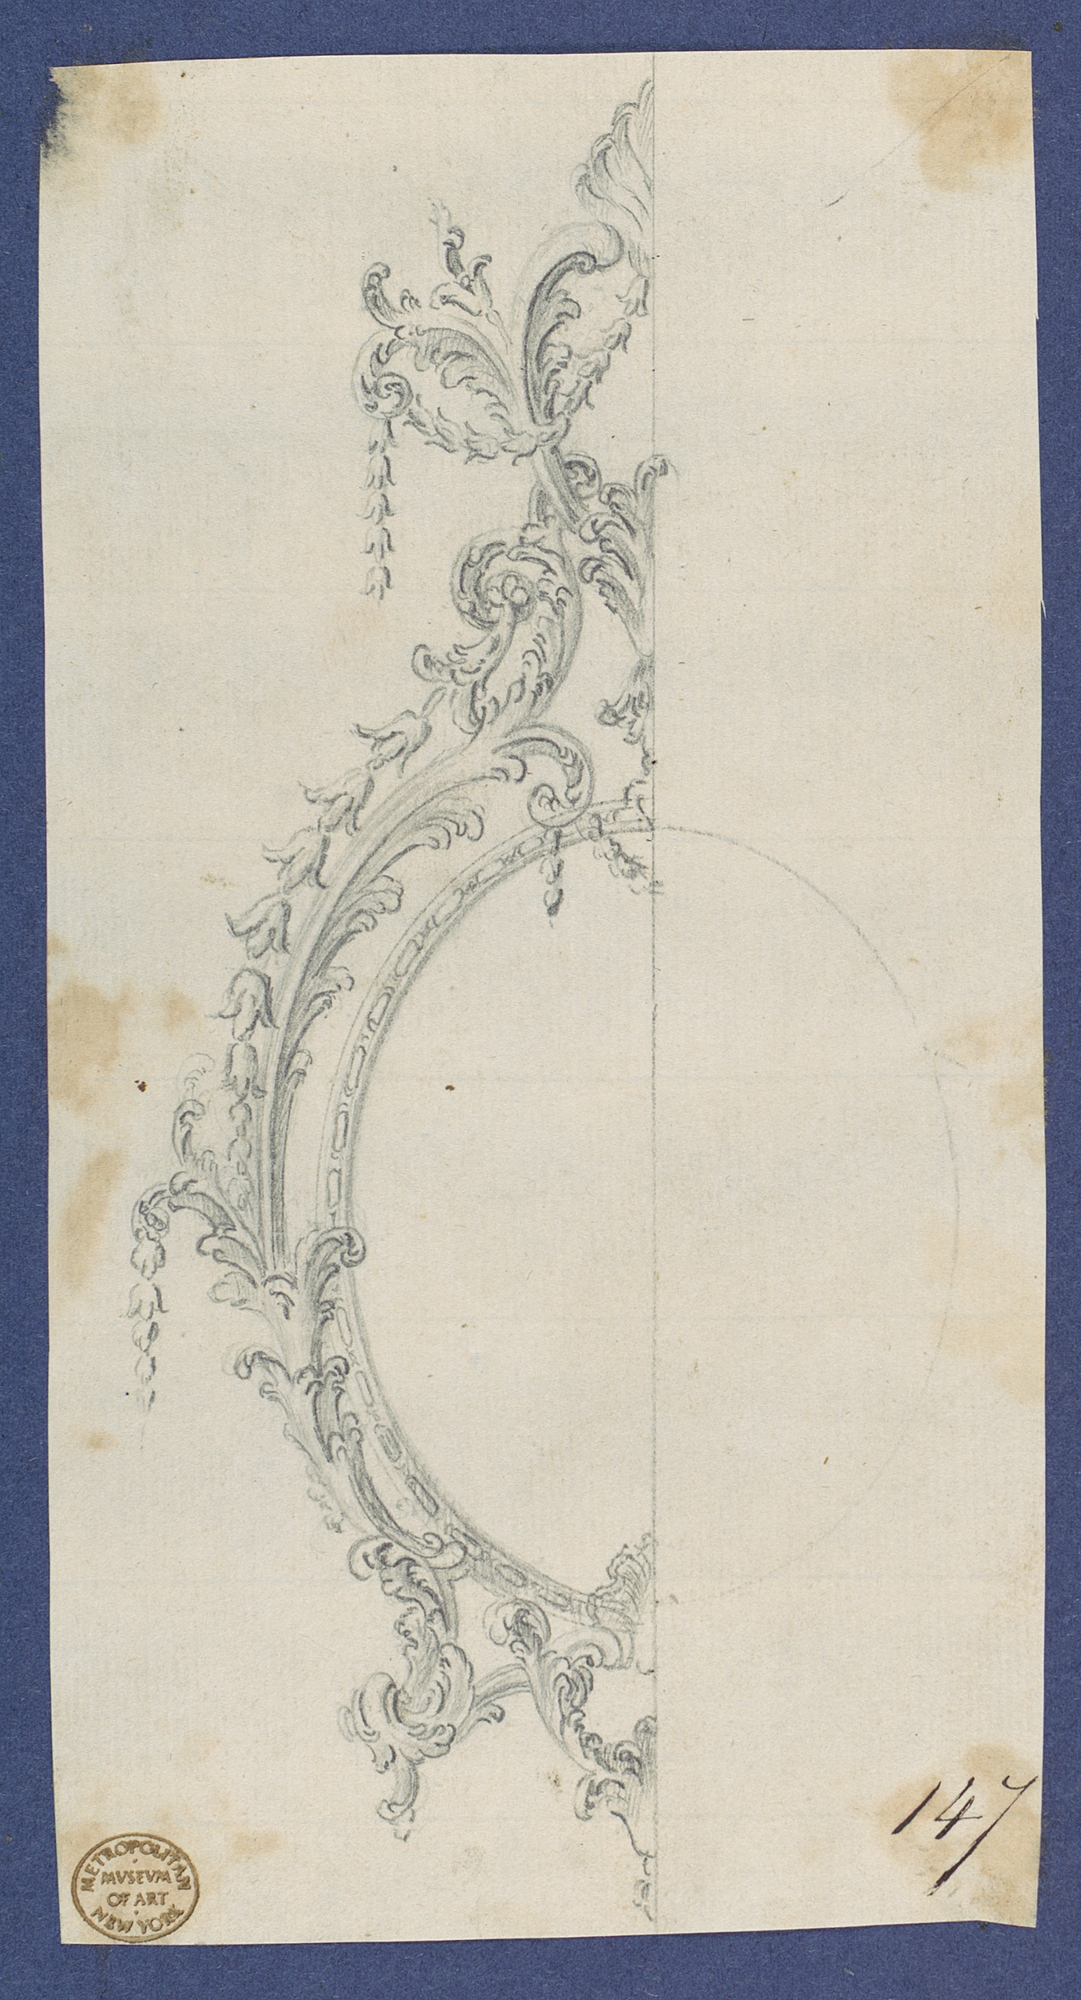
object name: drawing ornament architecture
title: Pier Glass Frame, in Chippendale Drawings, Vol. I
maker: thomas chippendale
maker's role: artist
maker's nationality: british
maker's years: 1718-1779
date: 1753-1762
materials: graphite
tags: ornament